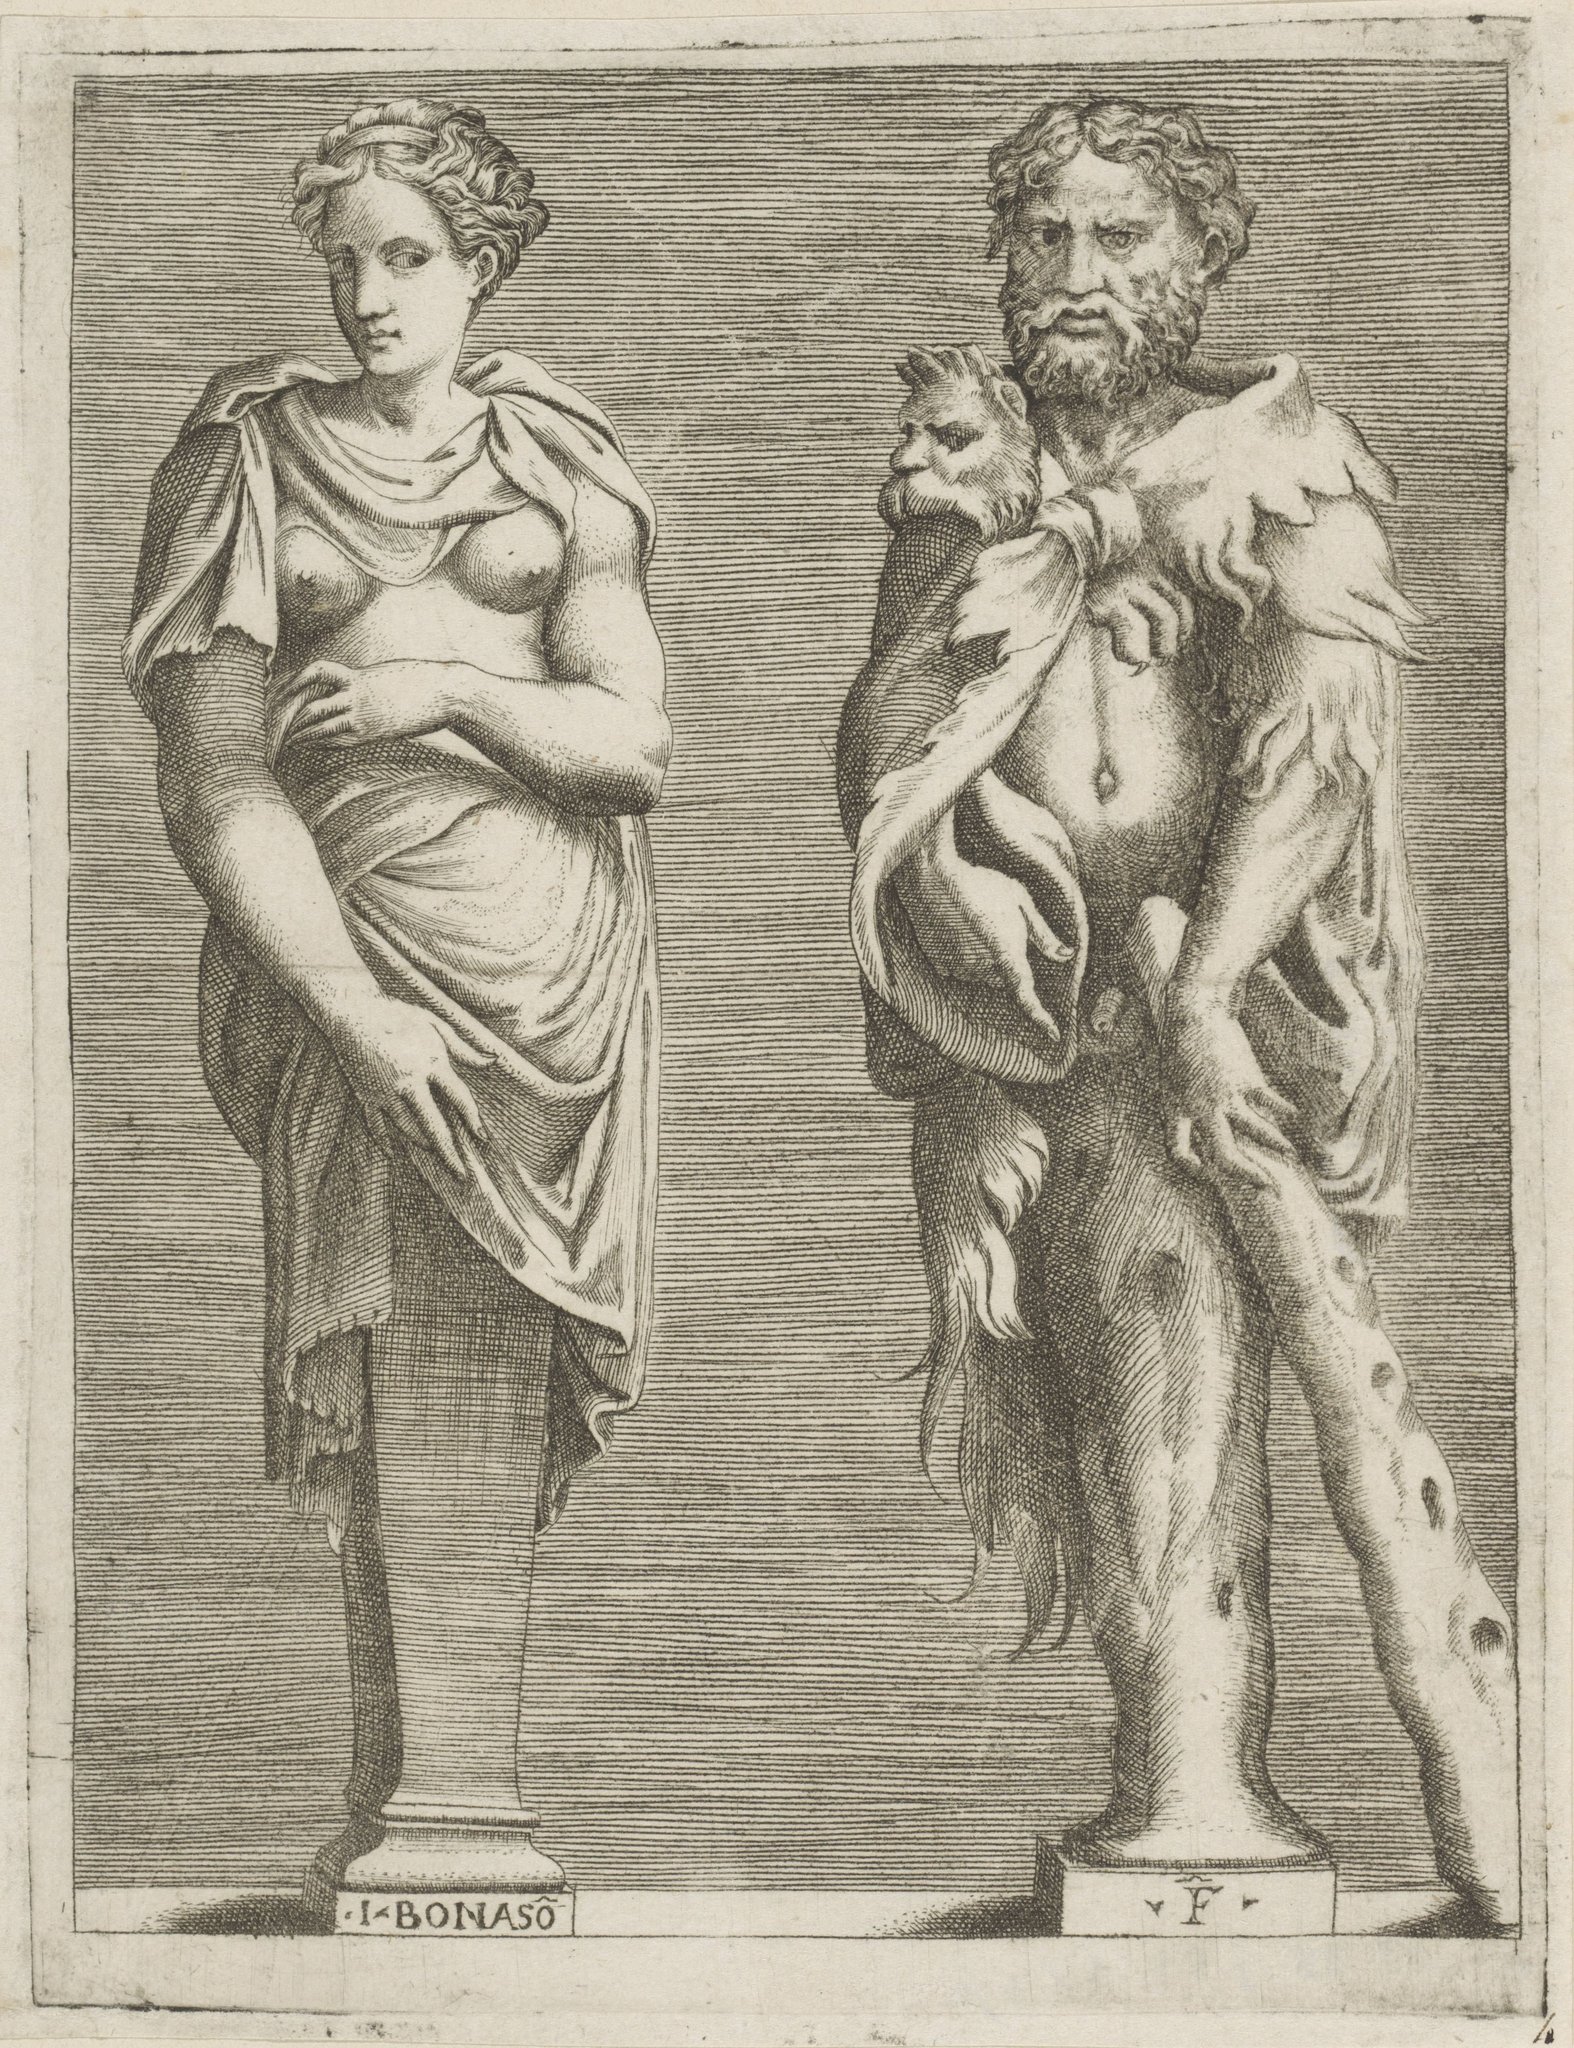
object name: print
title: Termen van Hercules en Deïanira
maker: giulio bonasone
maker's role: painter, print maker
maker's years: 1510-1576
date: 1501-1580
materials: paper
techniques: etching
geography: italy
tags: (story of) hercules (heracles), piece of sculpture, reproduction of a piece of sculpture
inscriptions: collector's mark: Lugt 11, number: ‘4’